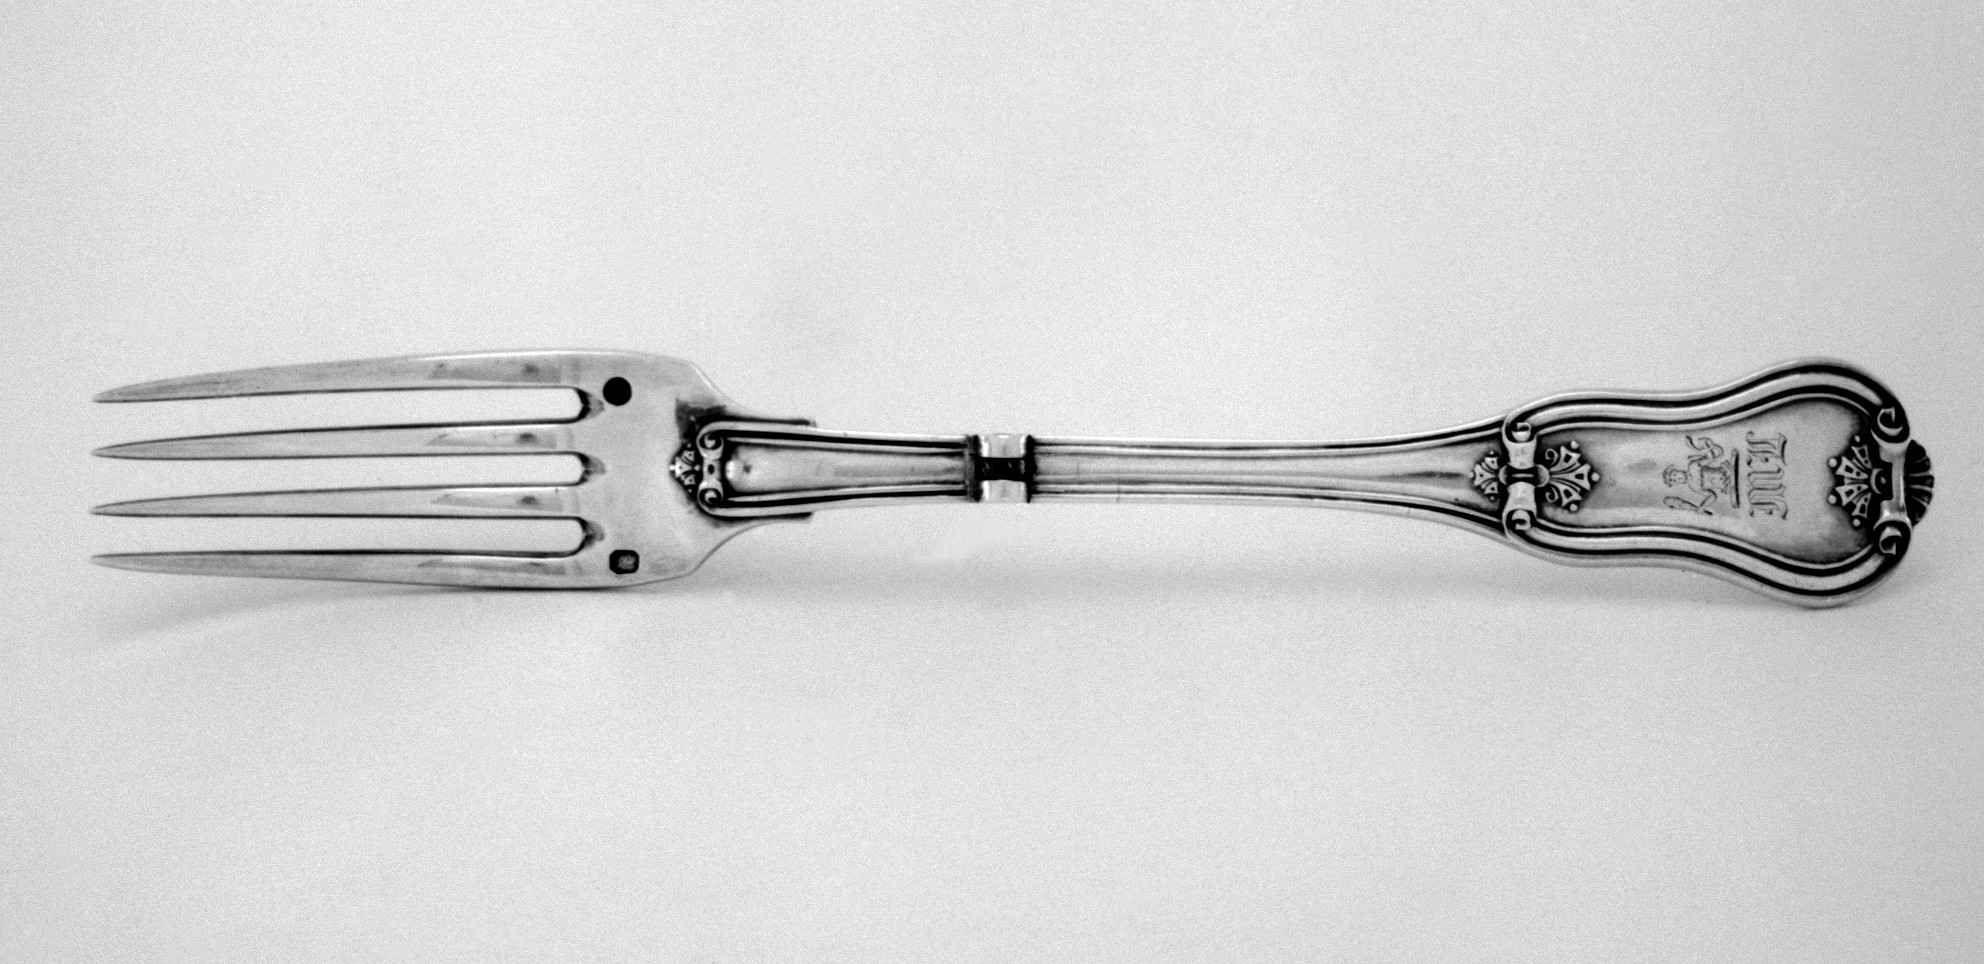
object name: spoon and fork combination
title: Traveling spoon and fork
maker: joseph-baptiste fuchs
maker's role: maker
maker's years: 1775-1875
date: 1833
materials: silver